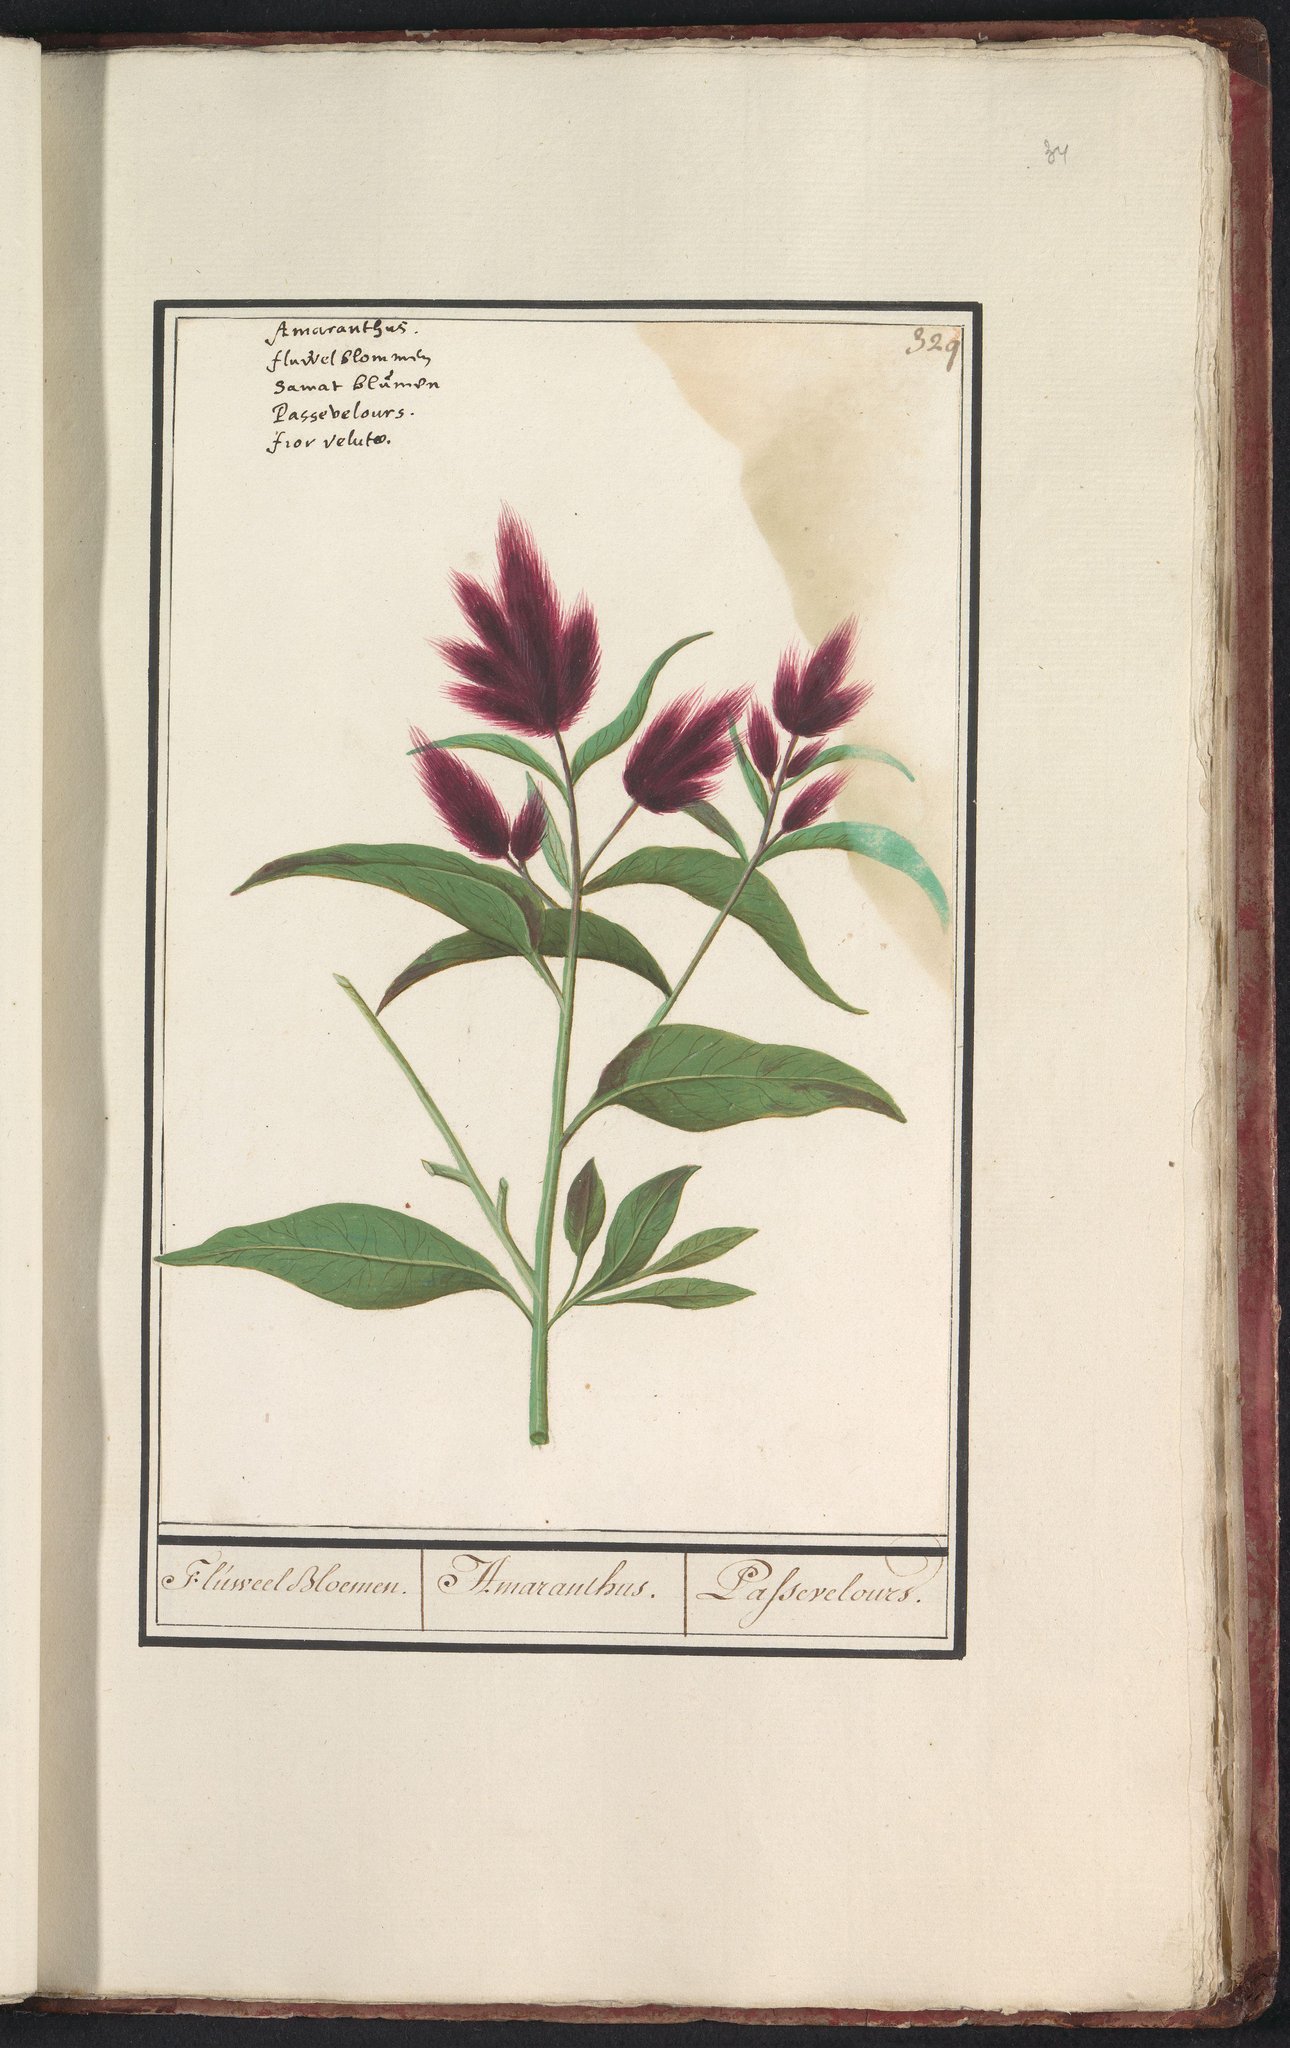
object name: drawing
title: Fluweel Bloemen. / Amaranthus. / Passevelours.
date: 1596-1610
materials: chalk, paint, ink, paper, watercolor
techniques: brush, pen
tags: flowers: amaranth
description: Amarant. Genummerd rechtsboven: 329. Linksboven de naam in vijf talen. Onderdeel van het vierde album met tekeningen van bloemen en paddestoelen. Elfde van twaalf albums met tekeningen van dieren, vogels en planten bekend rond 1600, gemaakt in opdracht van keizer Rudolf II. Met toelichting in Nederlands, Latijn en Frans.